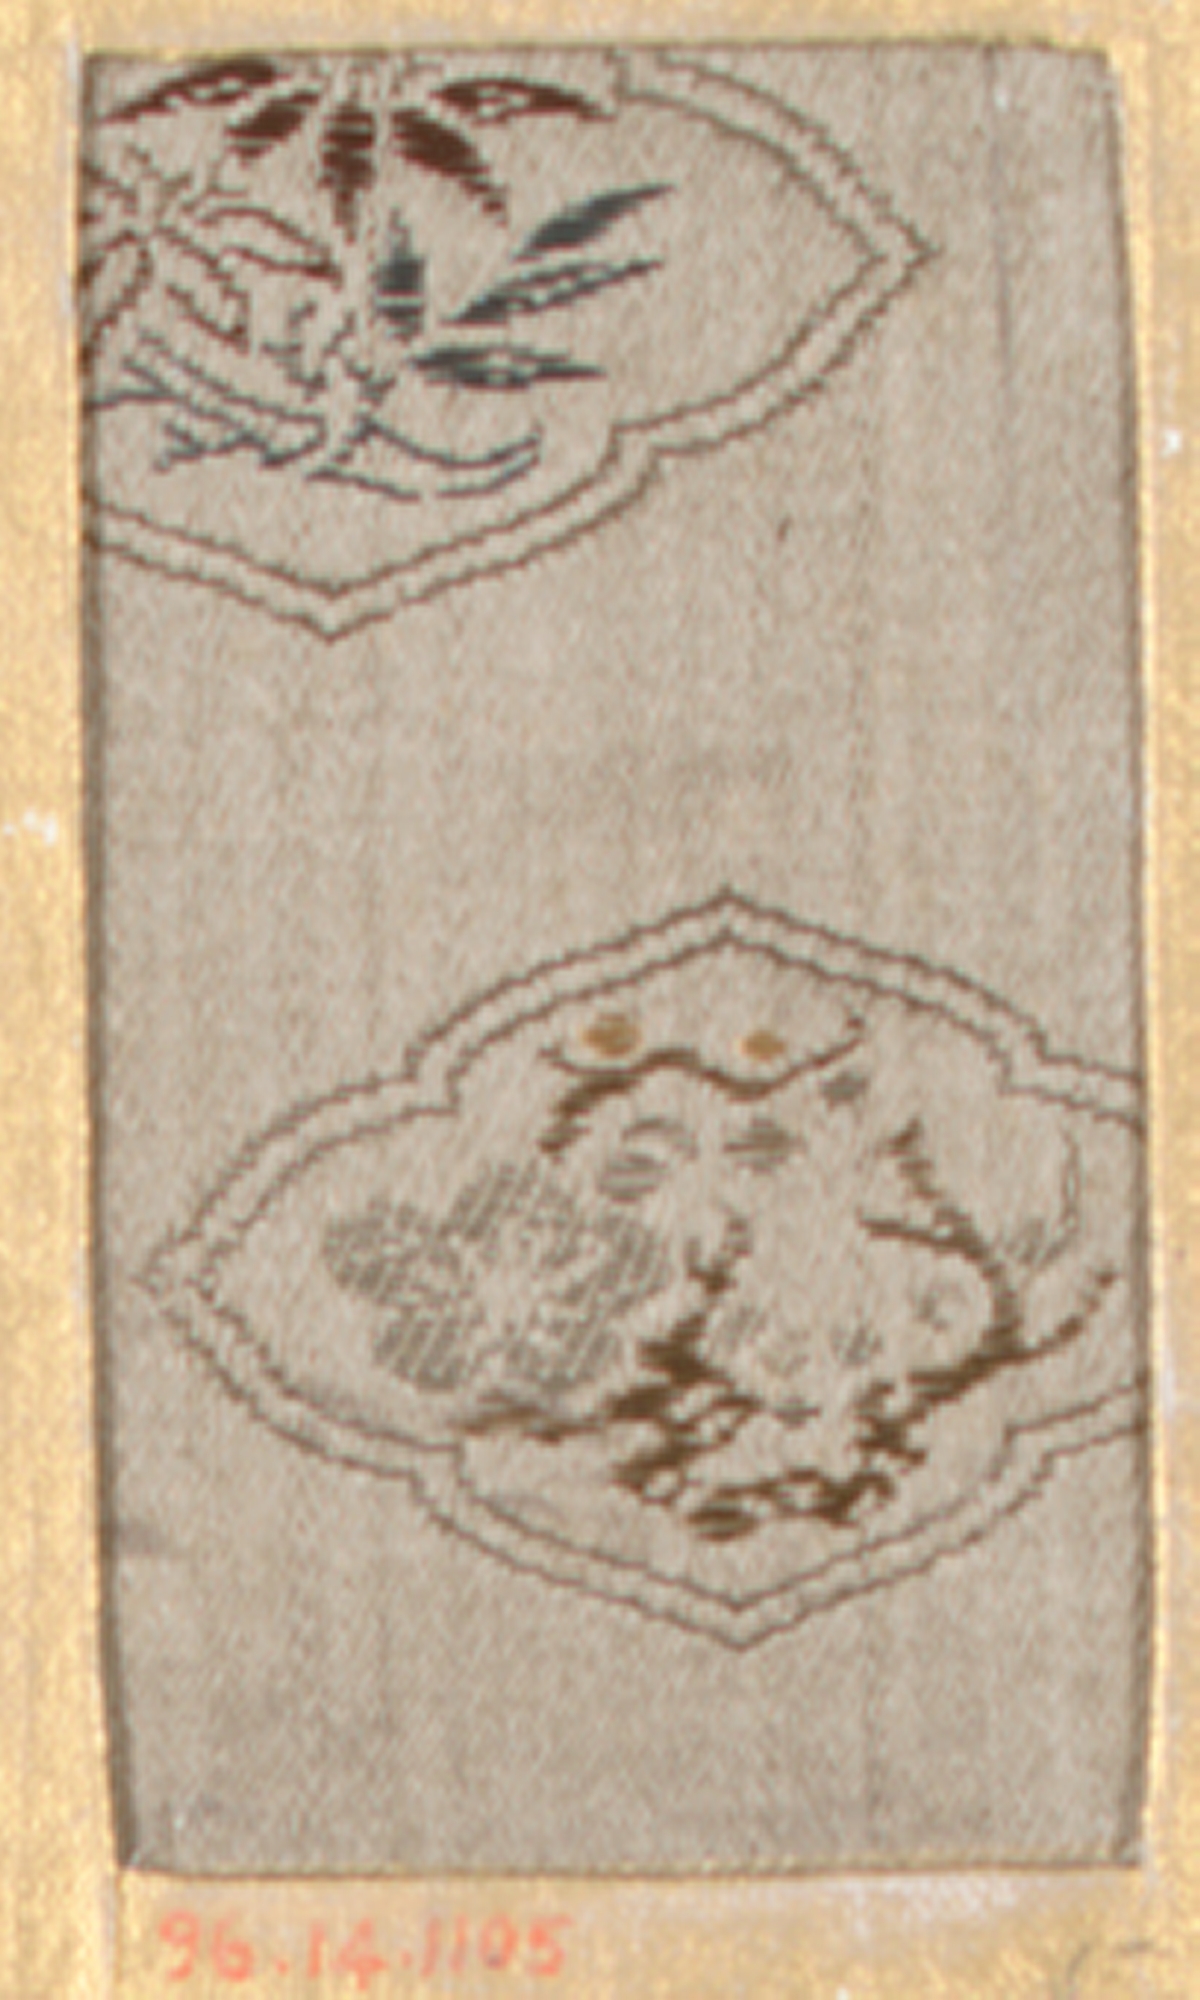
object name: piece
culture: japanese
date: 1701-1900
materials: silk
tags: flowers